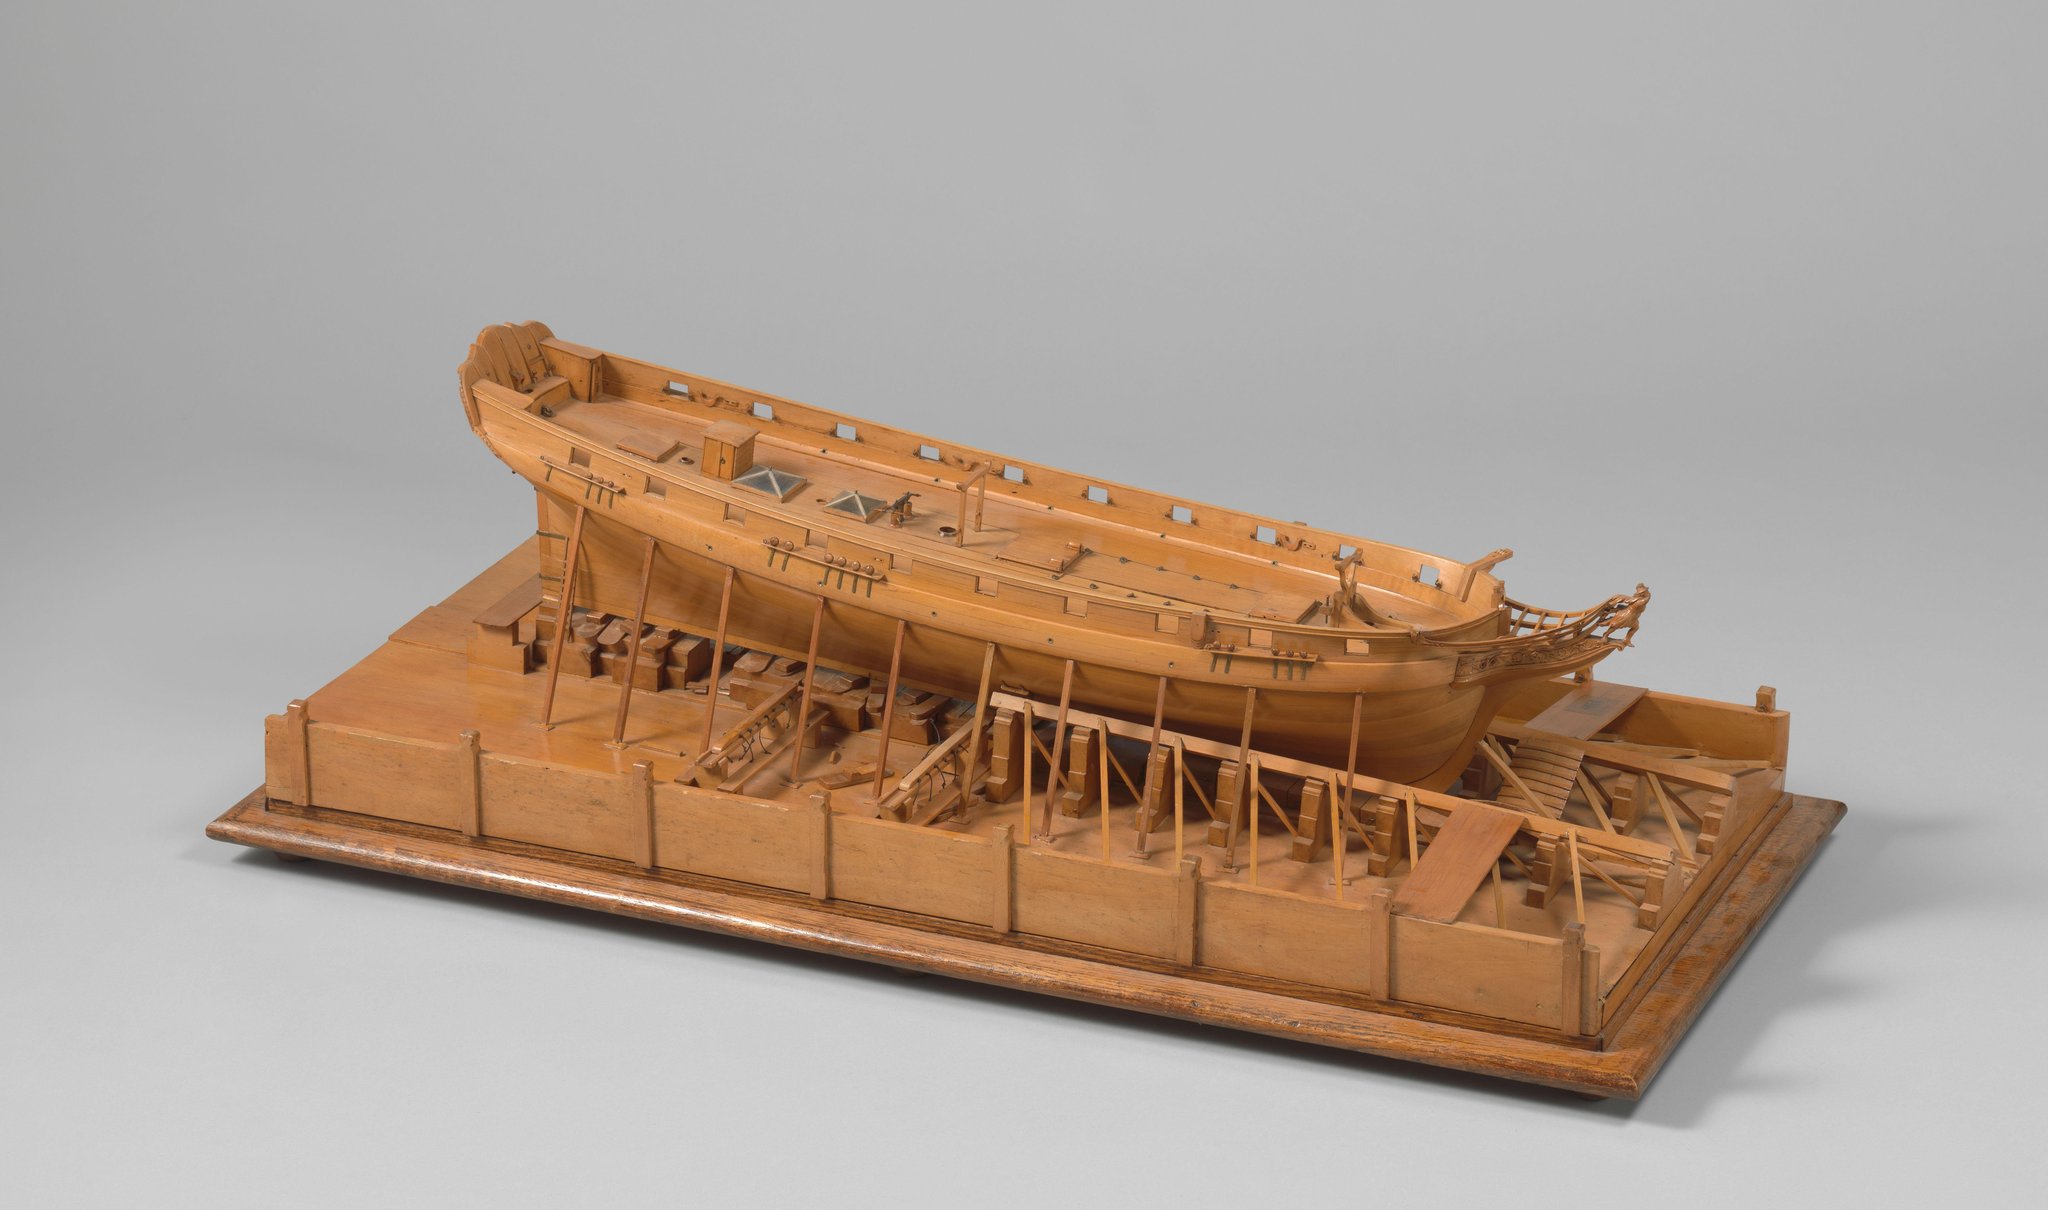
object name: hull model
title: Model of a 20-Gun Sloop of War on a Slipway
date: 1840-1849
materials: brass, glass, fiber, wood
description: This model shows the hull of a corvette – a small warship – under construction on a slipway. The vessel is positioned according to Dutch custom with the bow launching first. The slipway has been reproduced in great detail. The model ship even has tiny wheels on its keel so that it can move along the slipway.